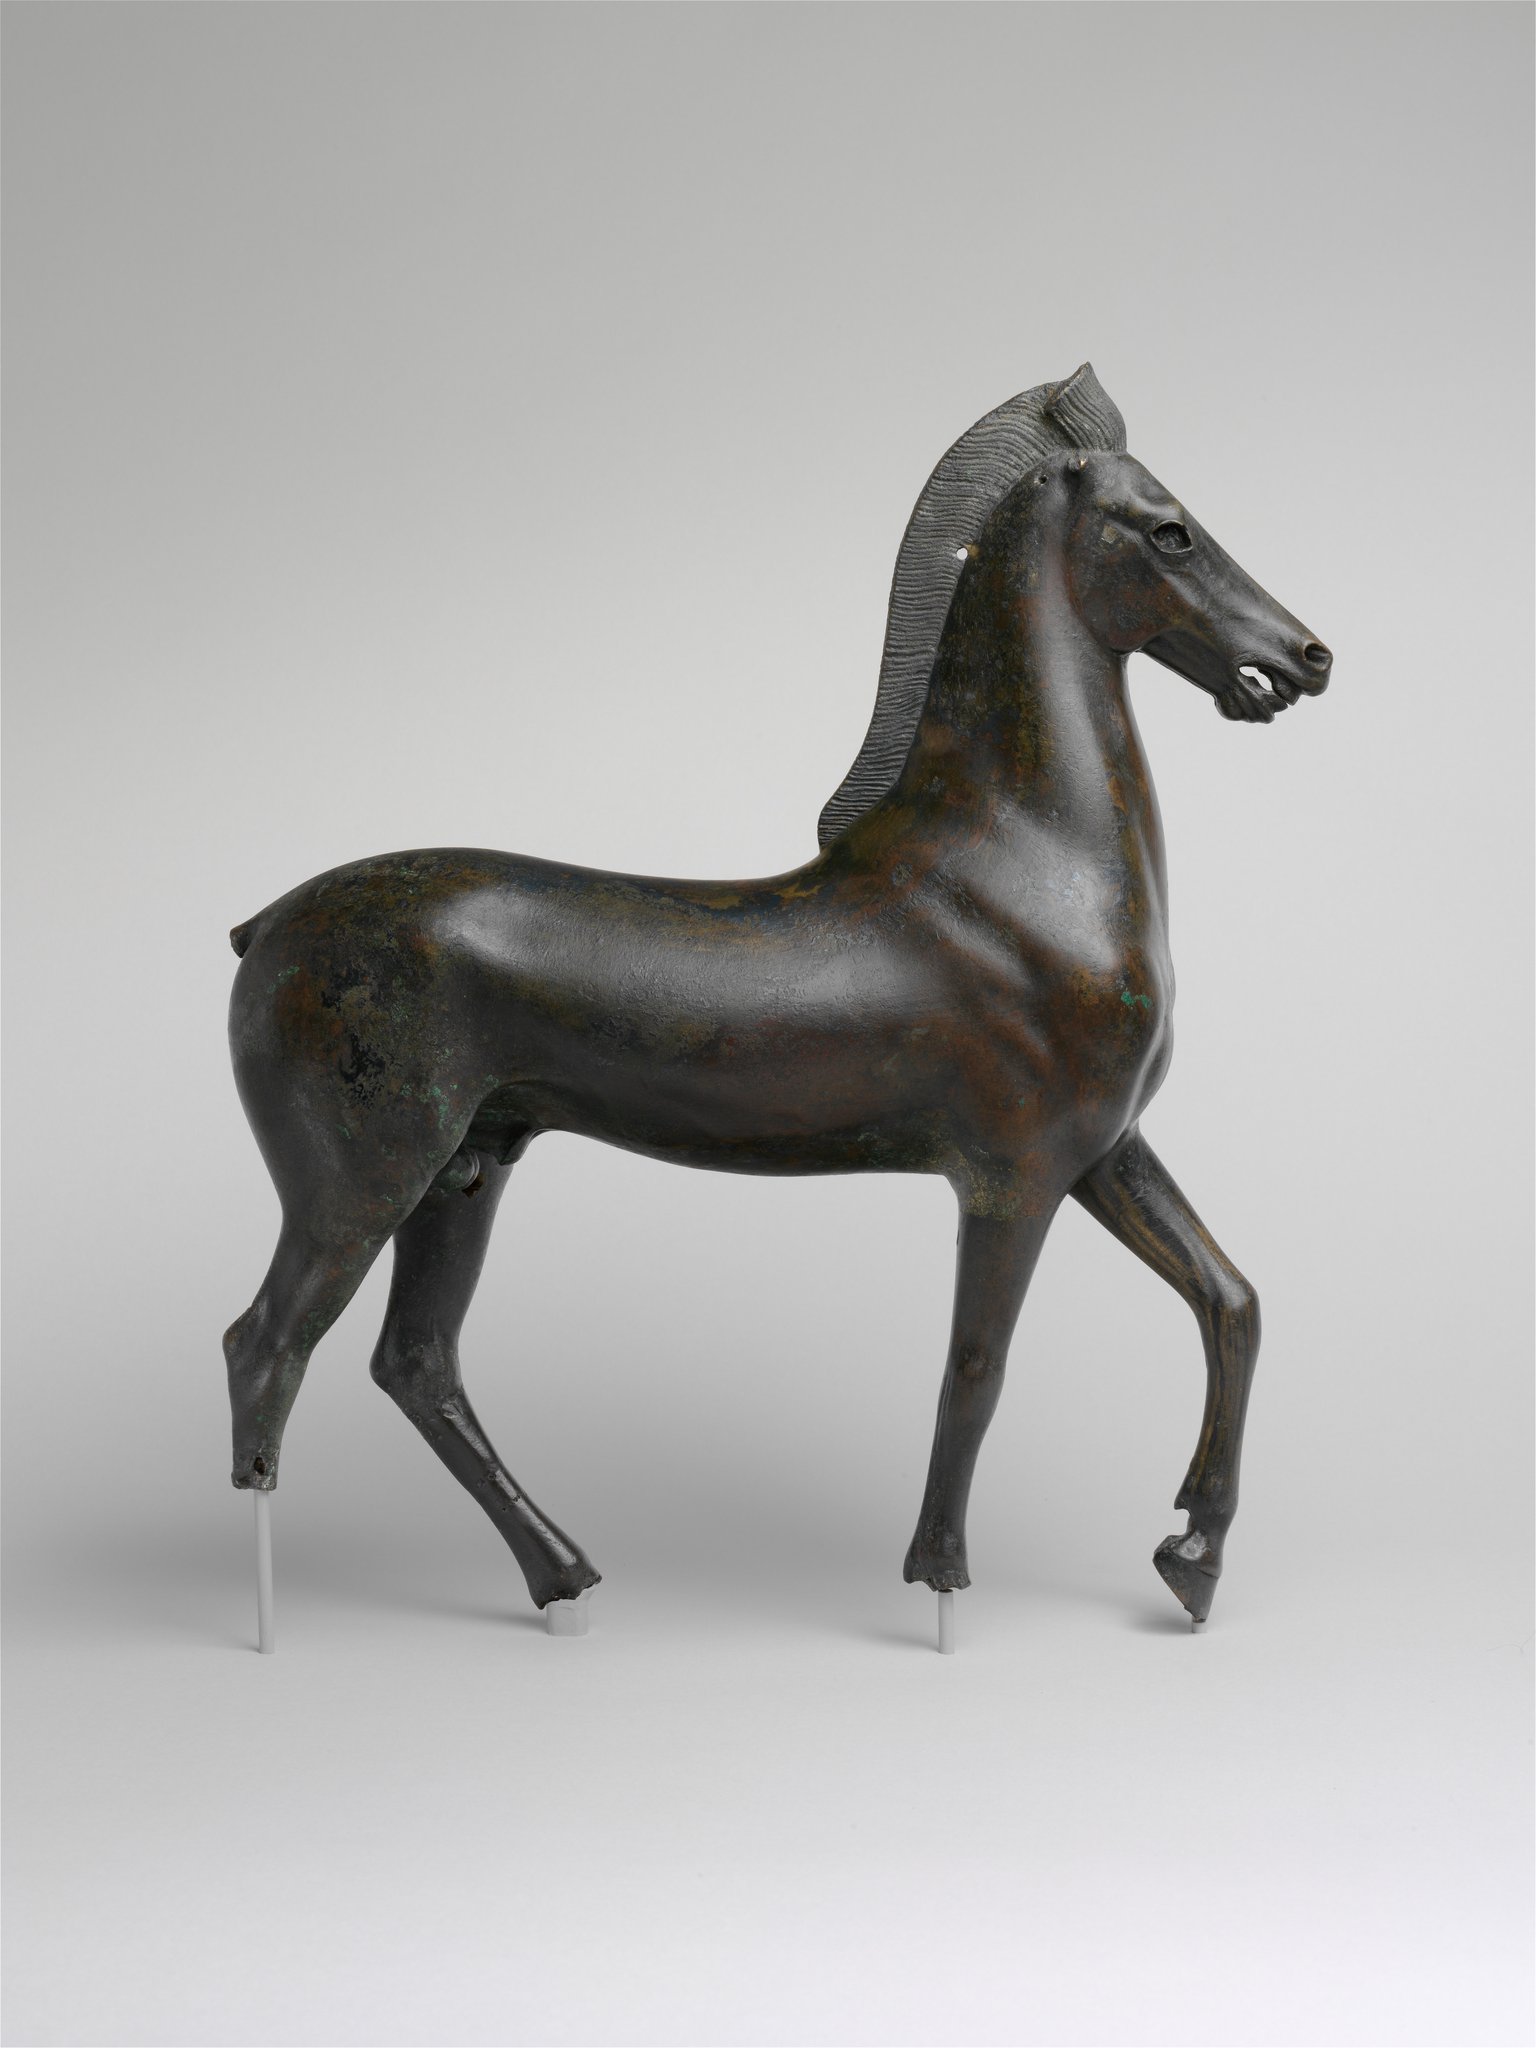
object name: statuette of a horse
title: Bronze statuette of a horse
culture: greek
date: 134-1 BCE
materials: bronze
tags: horses